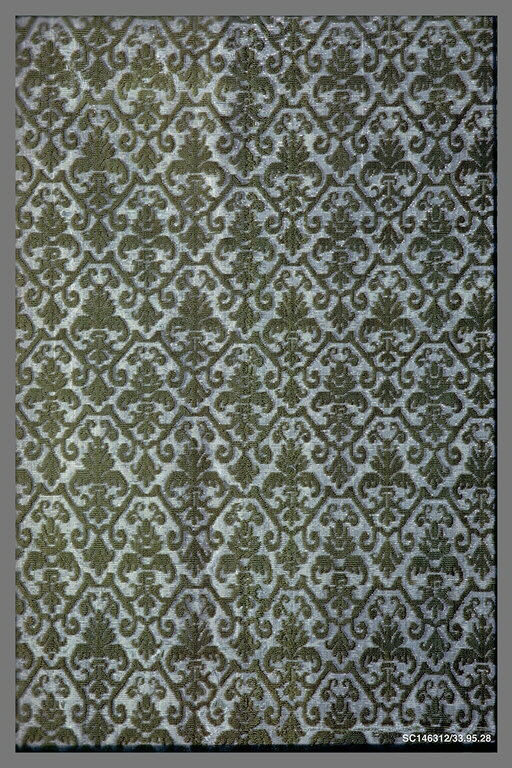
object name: fragment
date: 1551-1600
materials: metal thread, silk